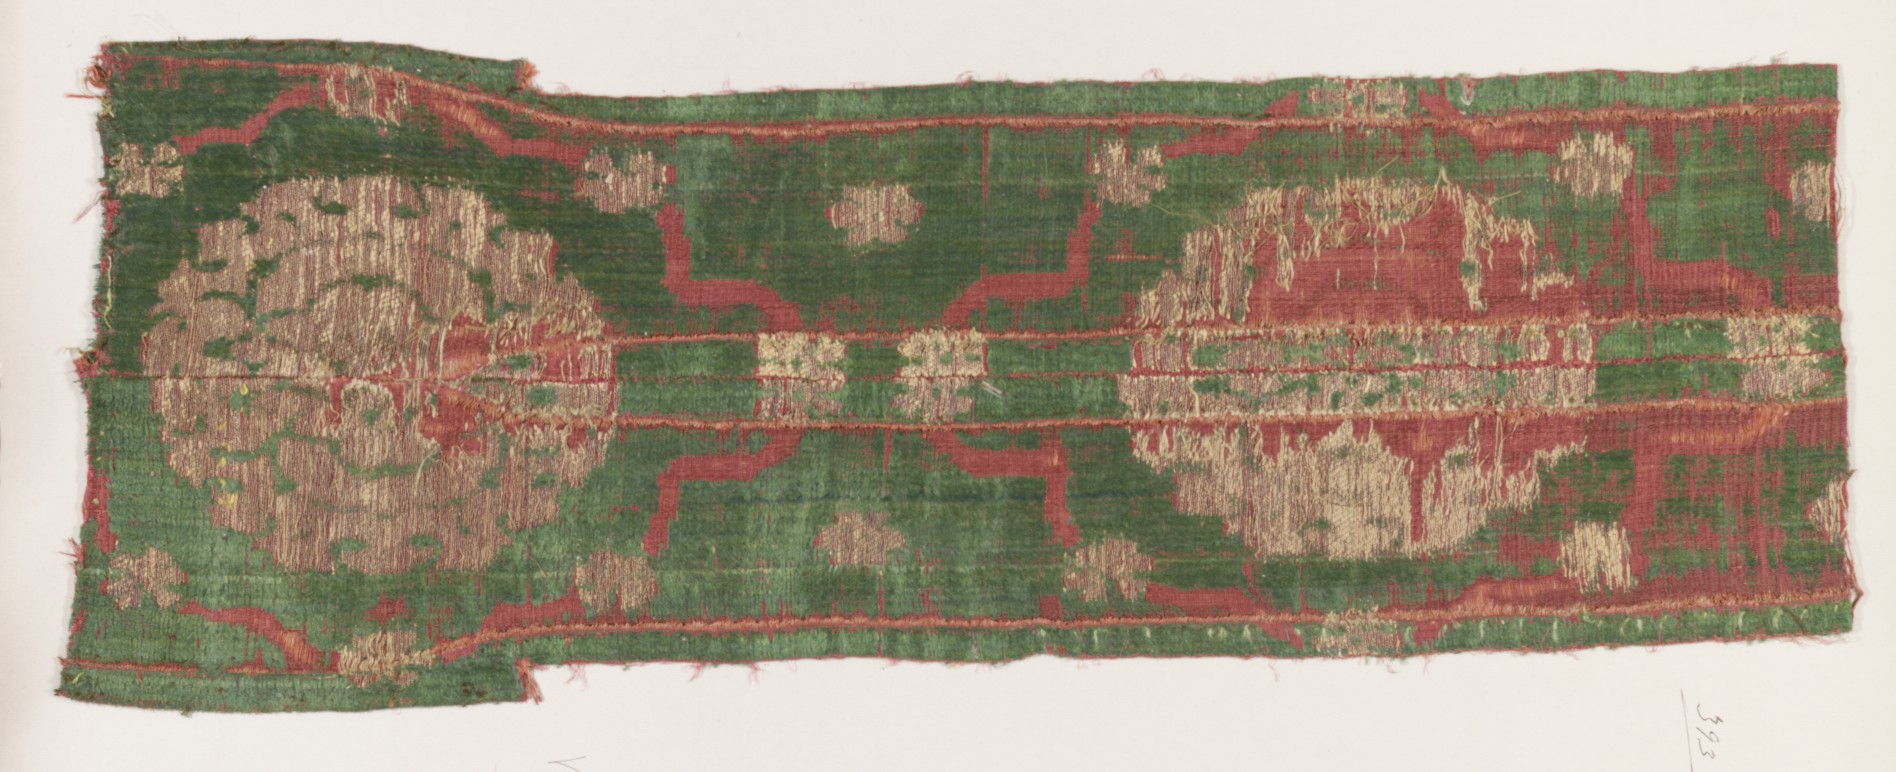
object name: fragment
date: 1401-1600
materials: metal thread, silk